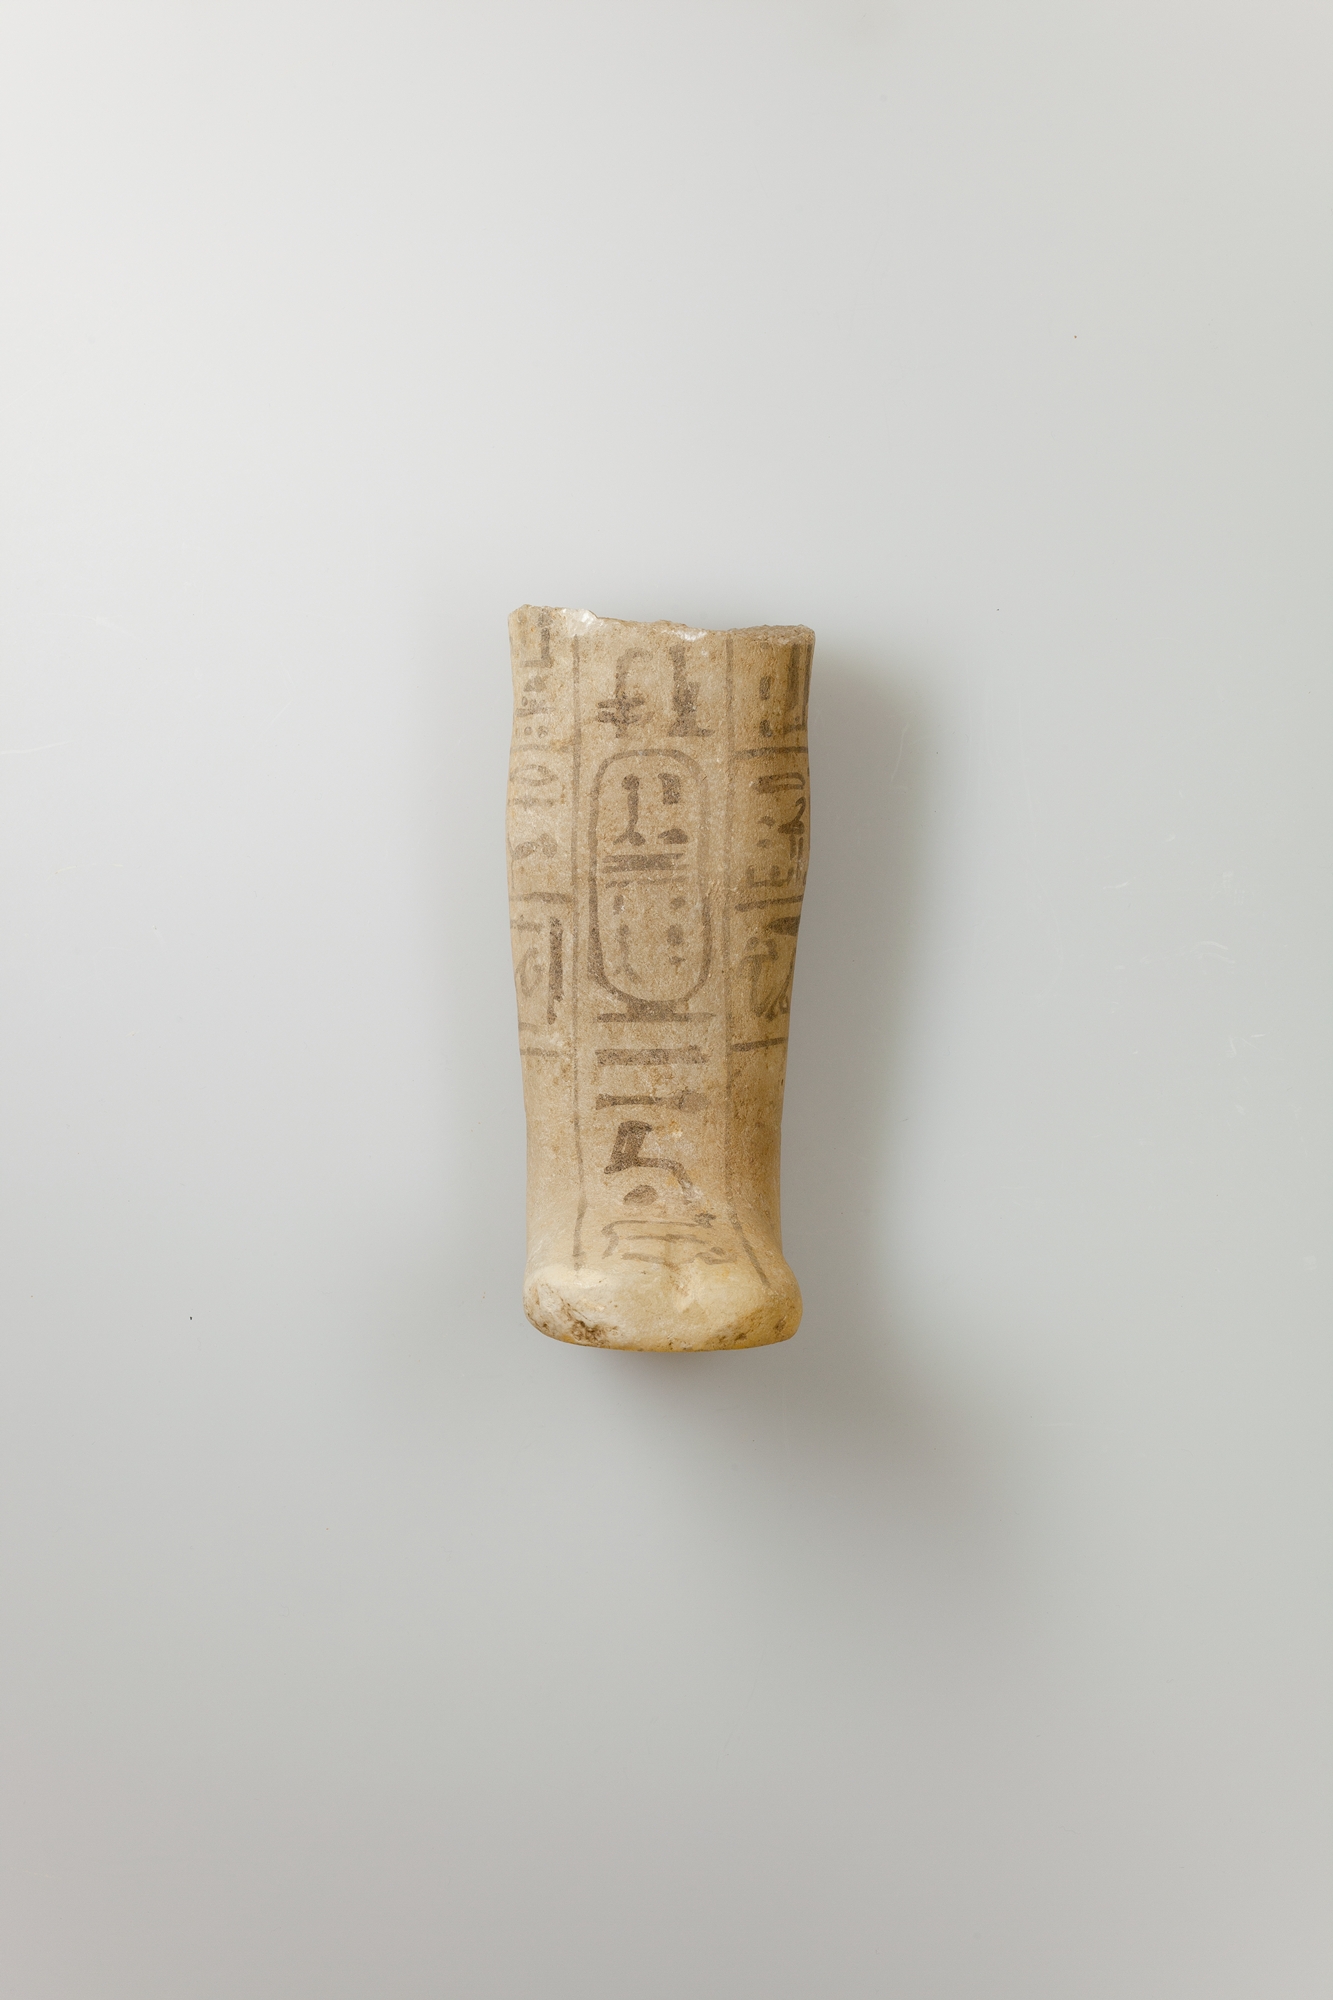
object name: shabti, siptah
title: Shabti of Siptah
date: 1194-1188 BCE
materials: stone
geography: egypt